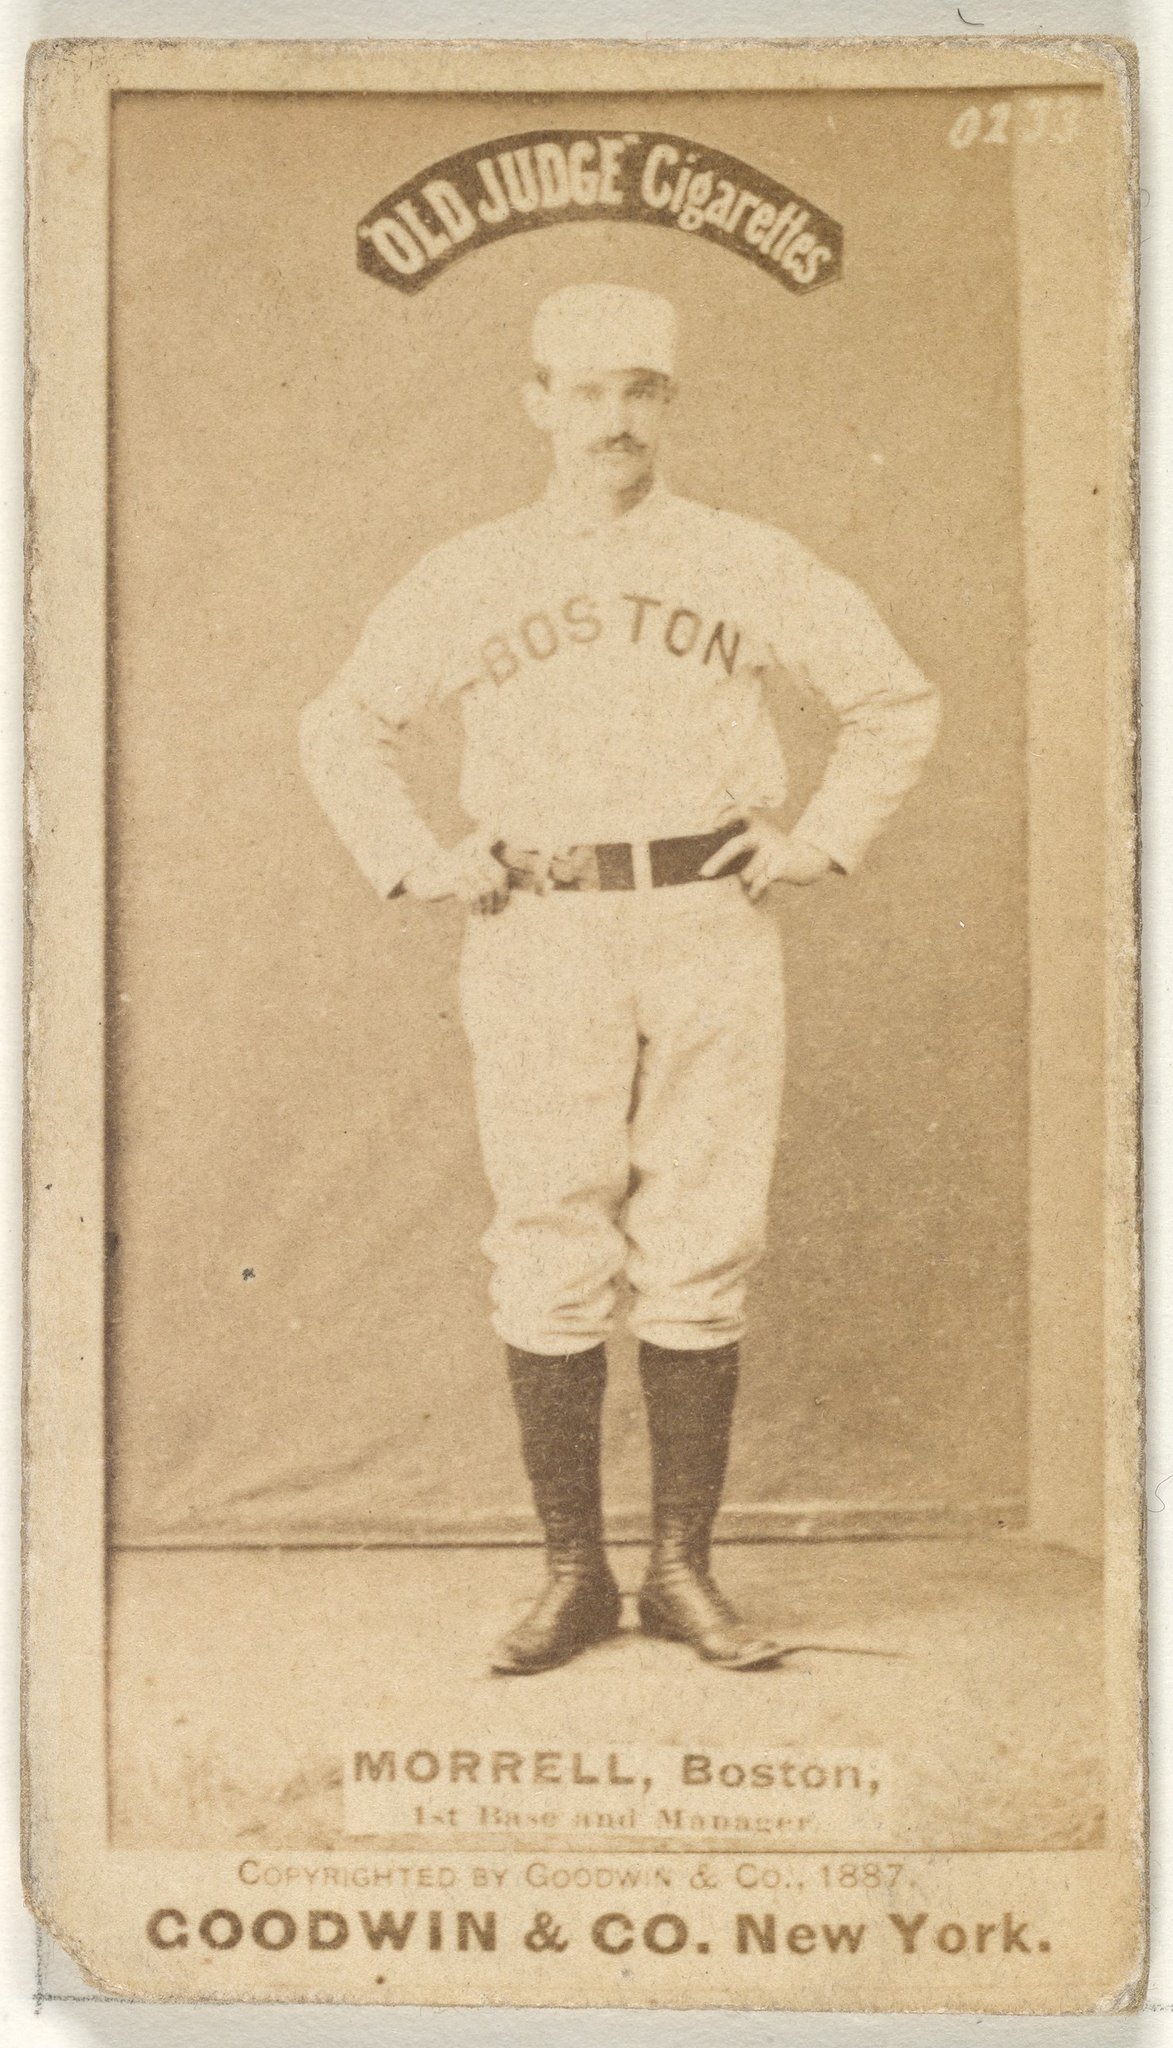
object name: baseball card, photograph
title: Morrell, 1st Base and Manager, Boston, from the Old Judge series (N172) for Old Judge Cigarettes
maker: goodwin & company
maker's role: publisher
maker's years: 1850-1950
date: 1887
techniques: albumen silver print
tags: men,portraits,baseball,athletes